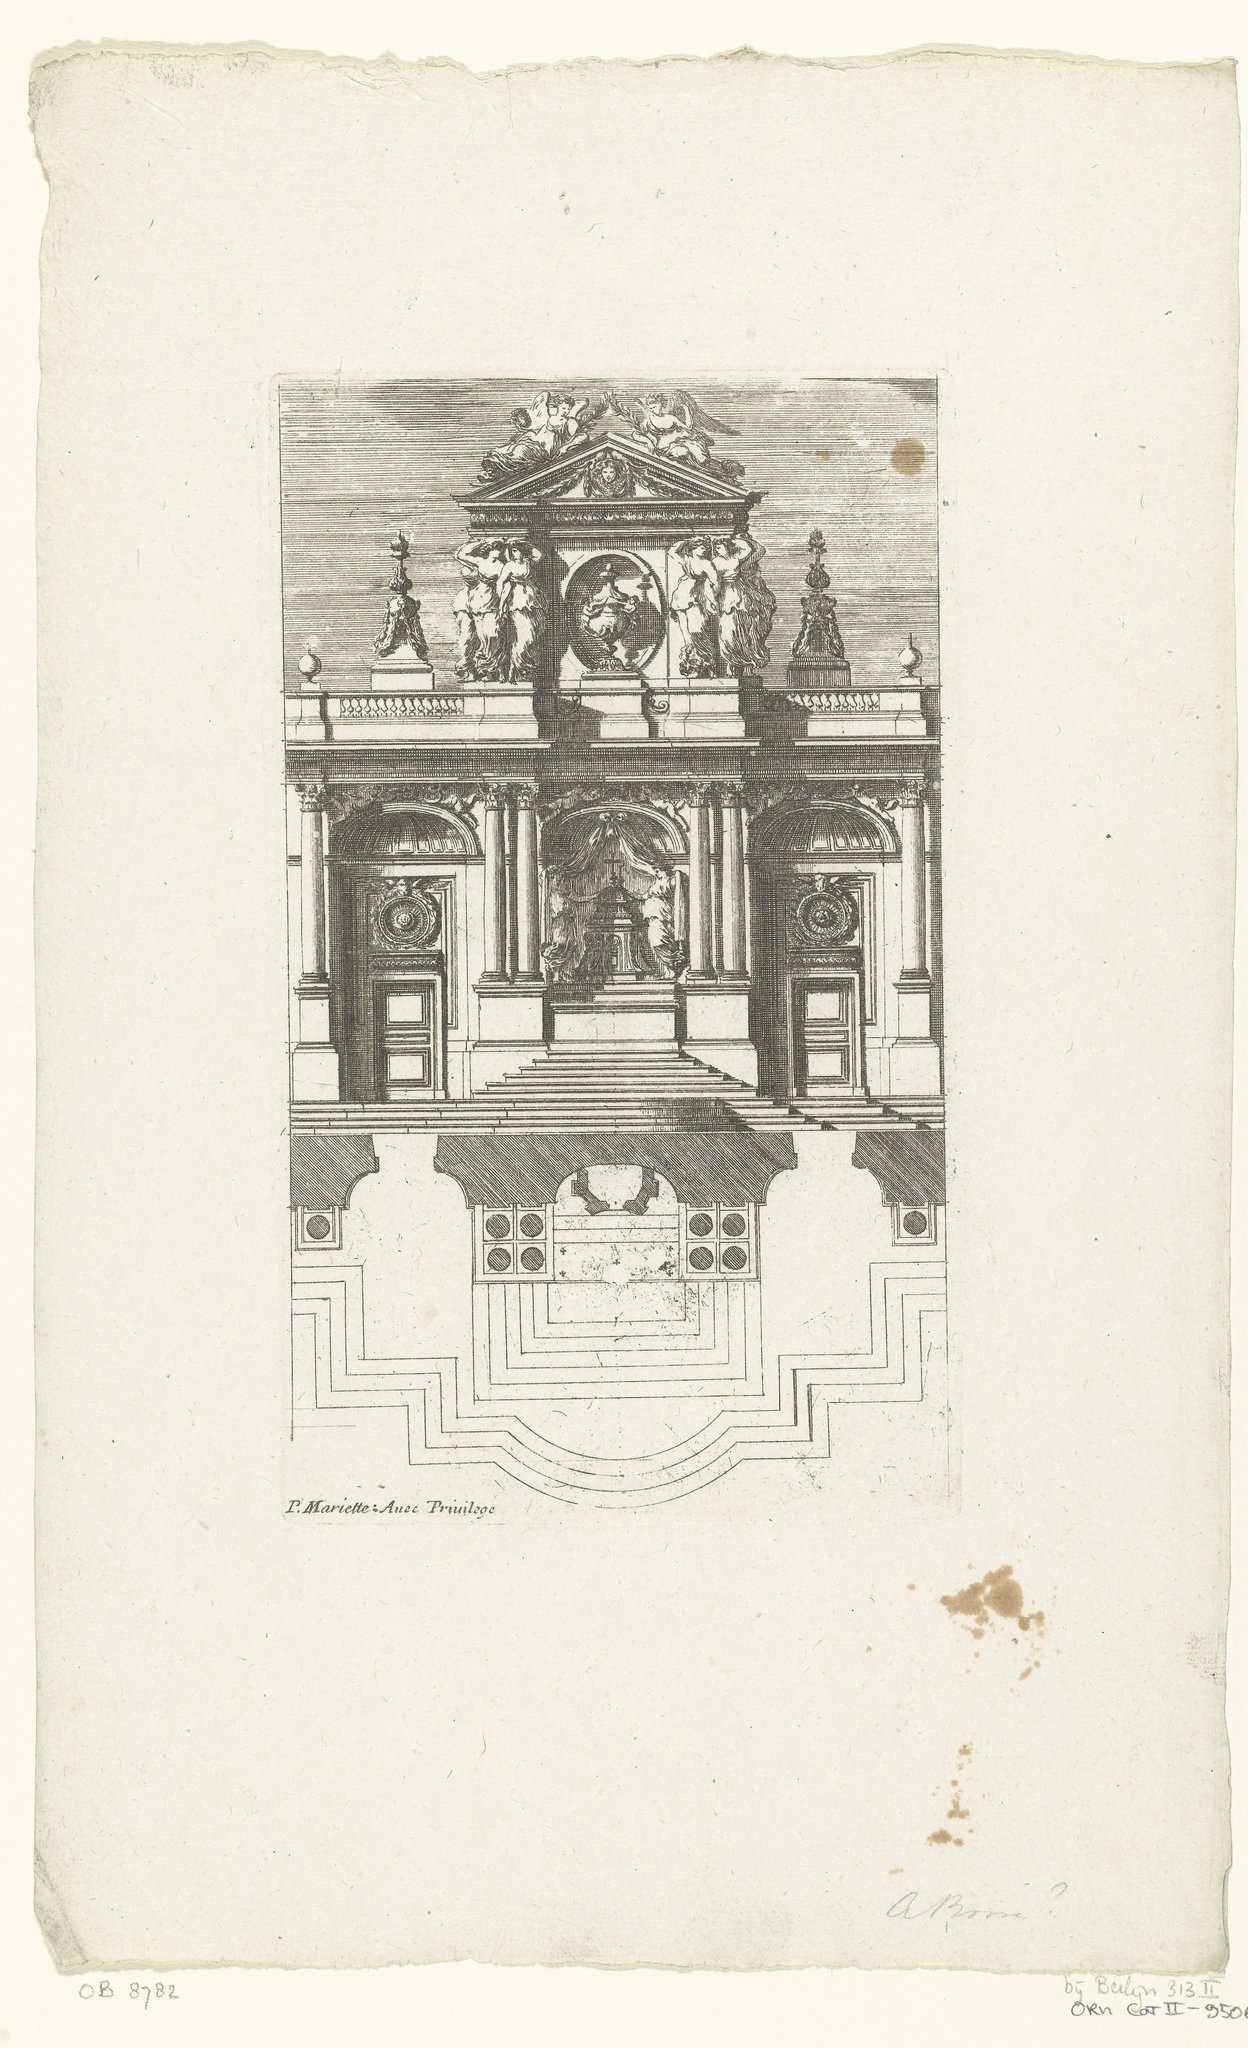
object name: ornament print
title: Altaren met plan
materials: paper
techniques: etching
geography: france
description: In het midden is een tweede verdieping aanwezig met bovenaan een fronton.